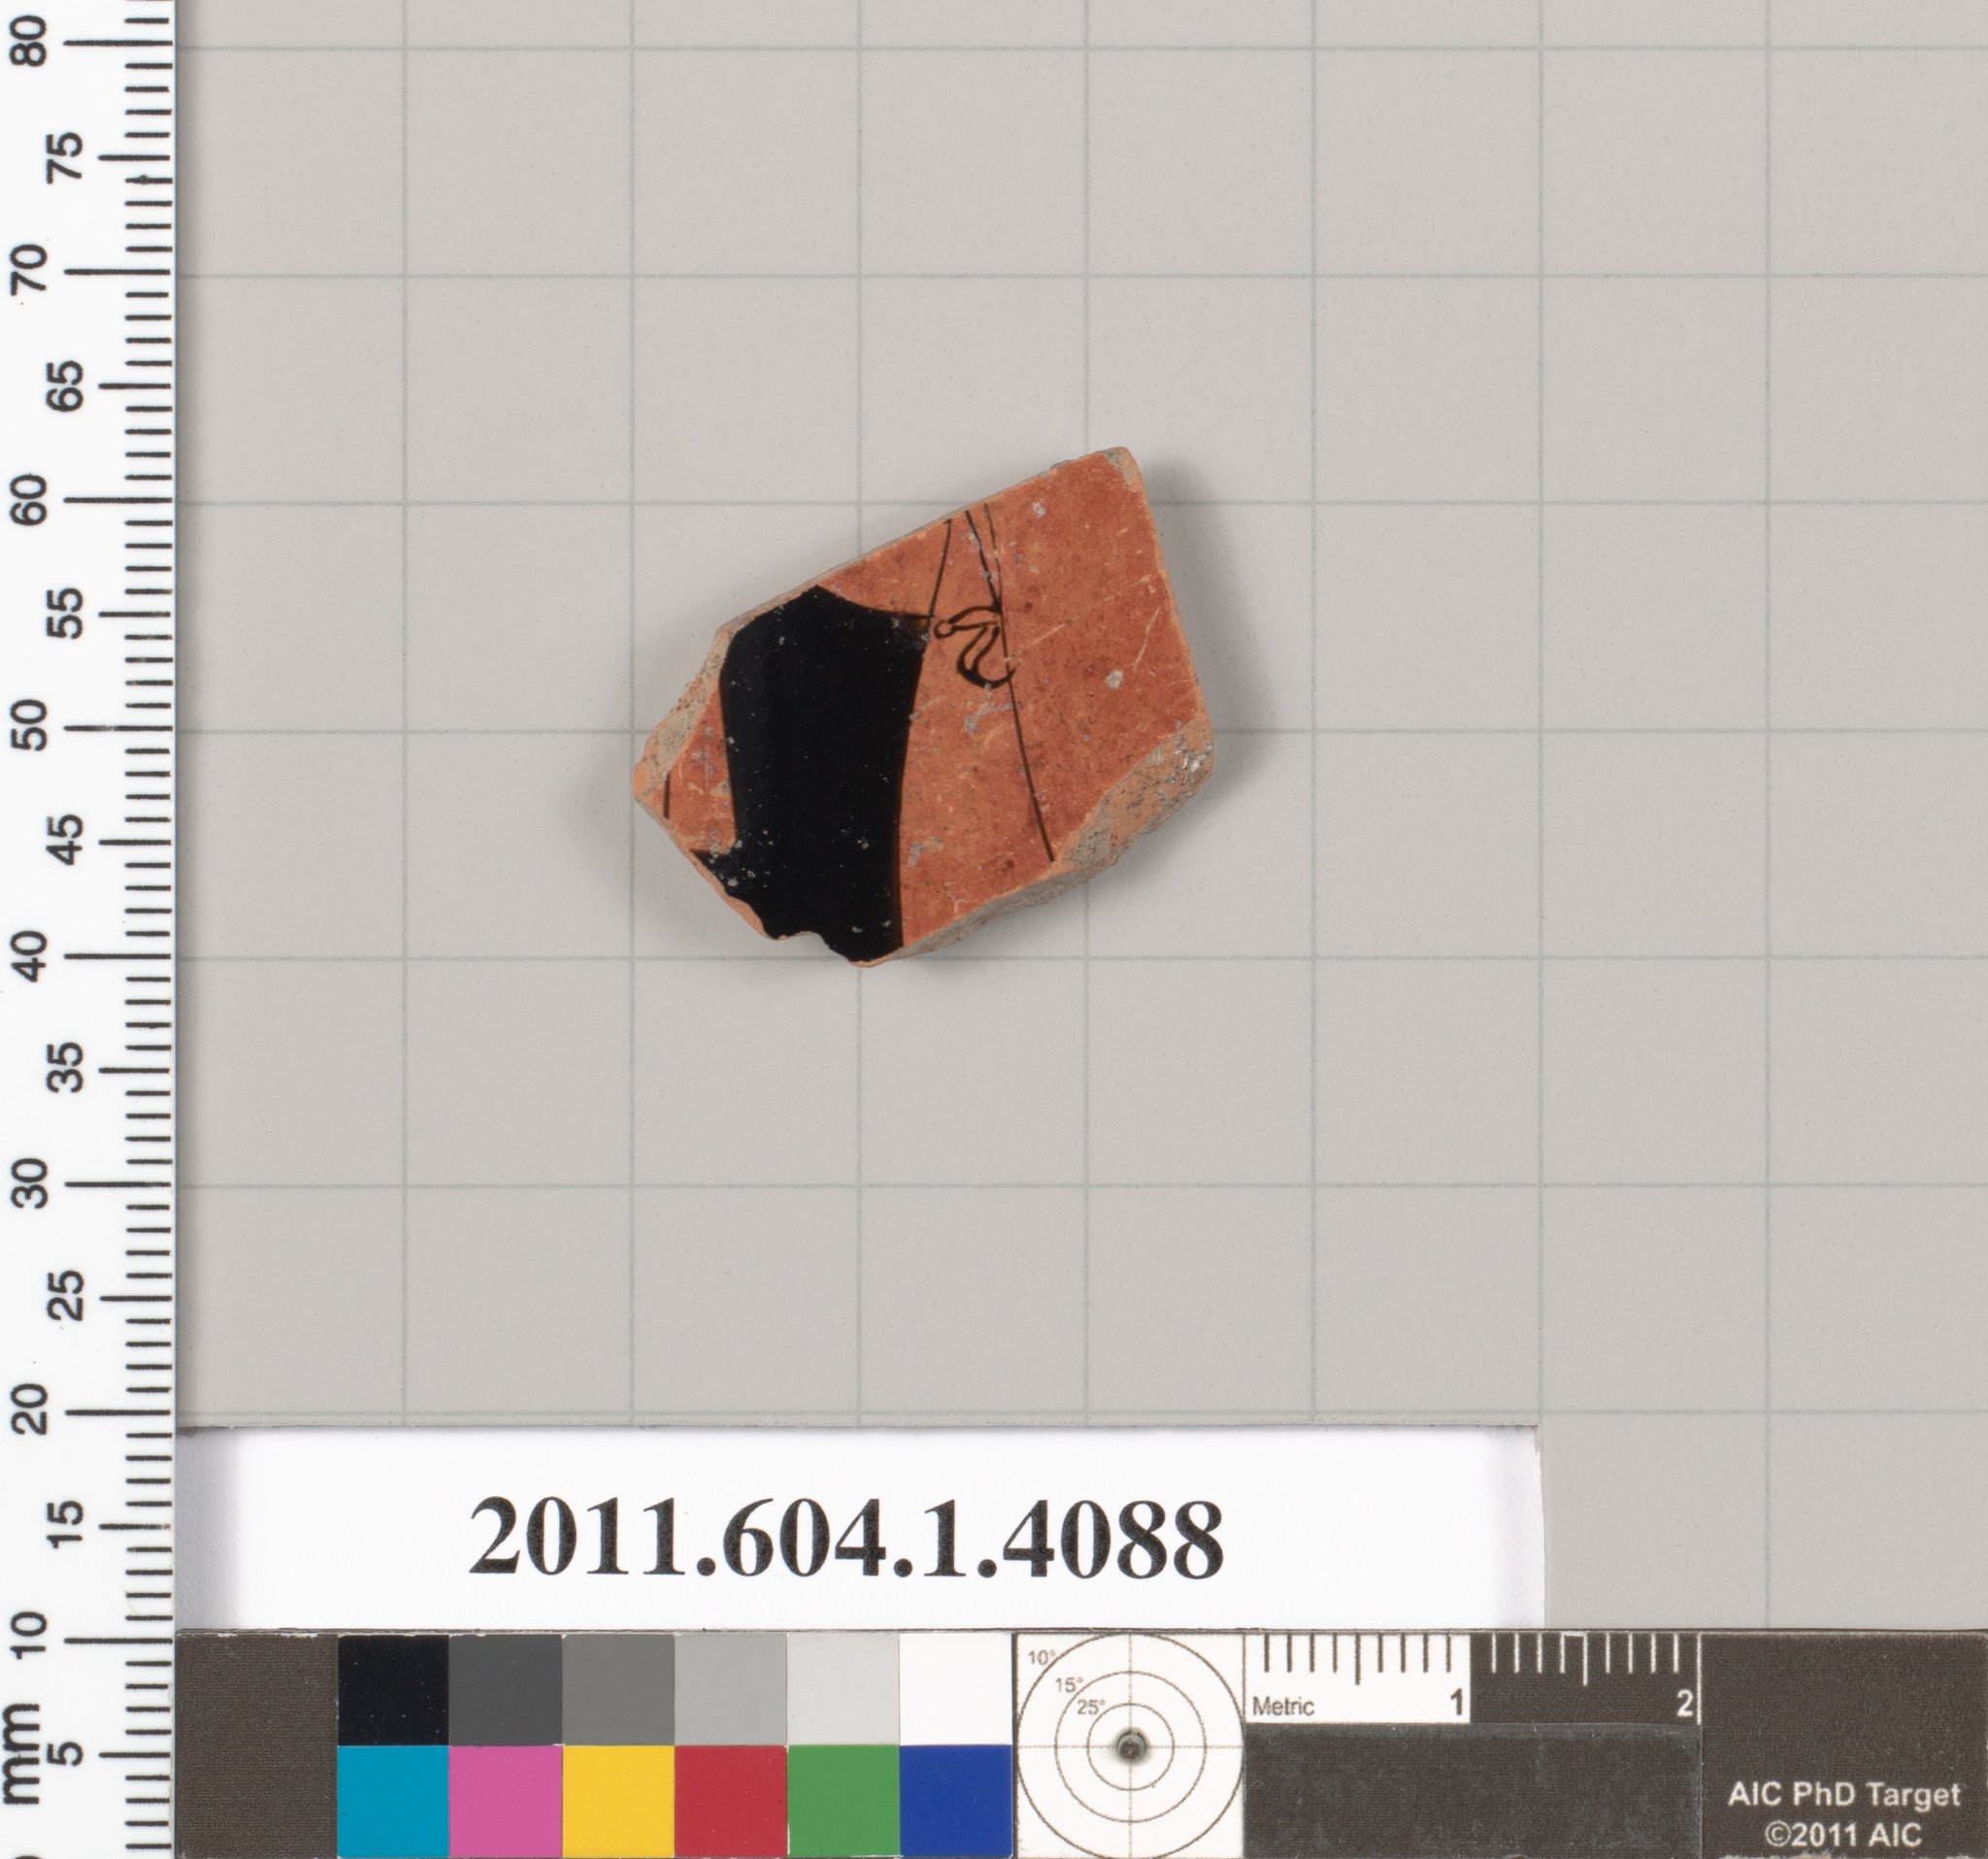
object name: kylix fragment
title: Terracotta fragment of a kylix (drinking cup)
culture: greek, attic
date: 490-480 BCE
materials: terracotta